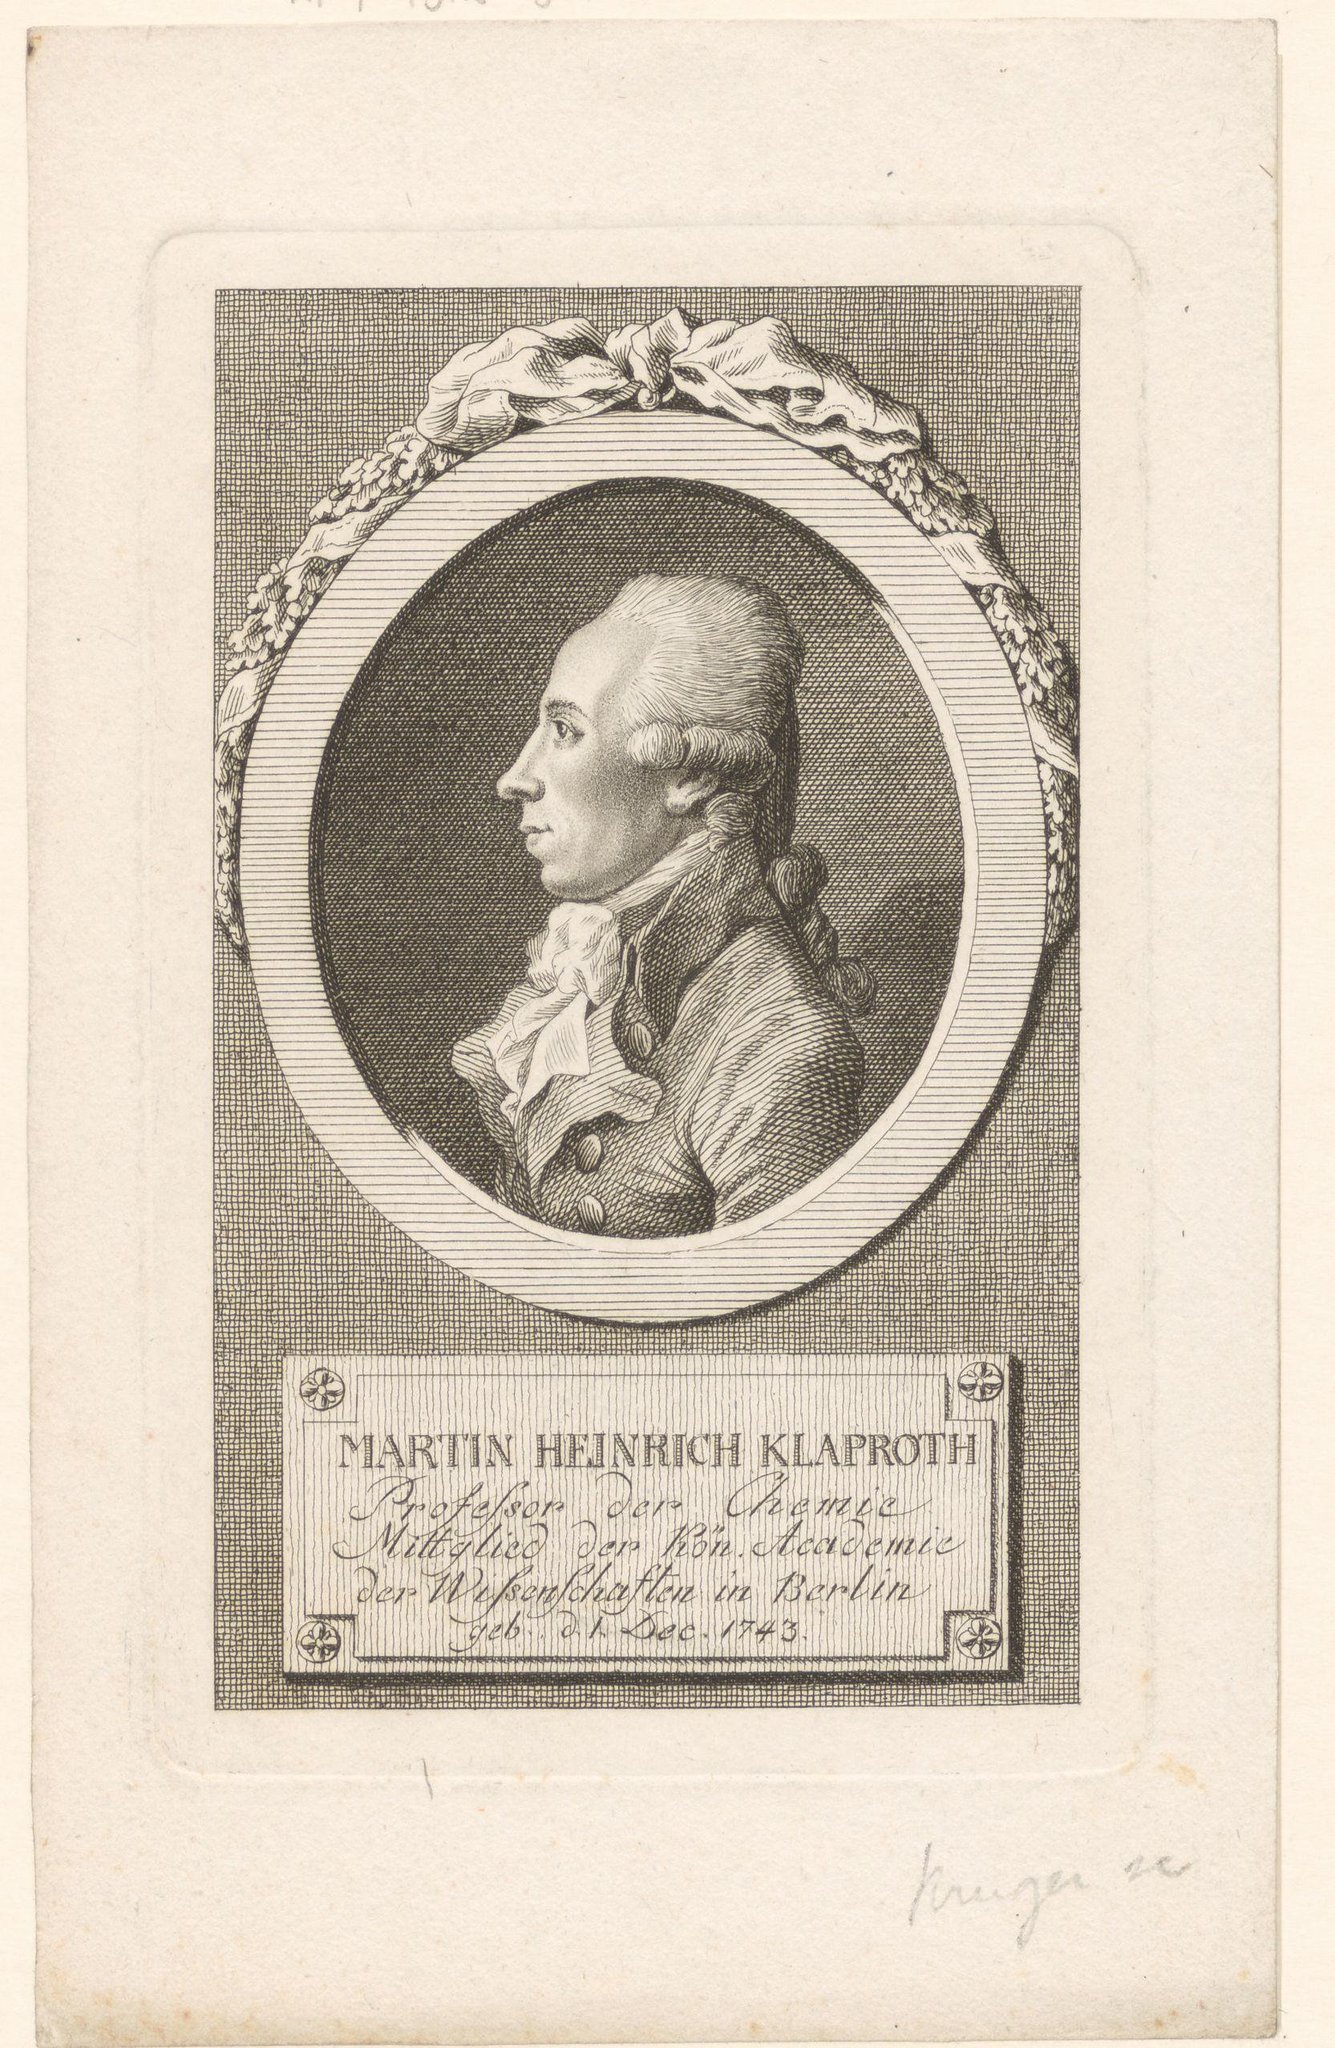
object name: print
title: Portret van Martin Heinrich Klaproth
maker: johann conrad krüger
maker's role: artist, painter, print maker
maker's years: 1733-1791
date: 1743-1791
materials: paper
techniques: engraving, etching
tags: chemistry (+ portrait of scholar, scientist), pharmacist, druggist, apothecary; pharmacy, drugstore, dispensing chemist (+ portrait of scholar, scientist), historical persons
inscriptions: collector's mark: Lugt 2228